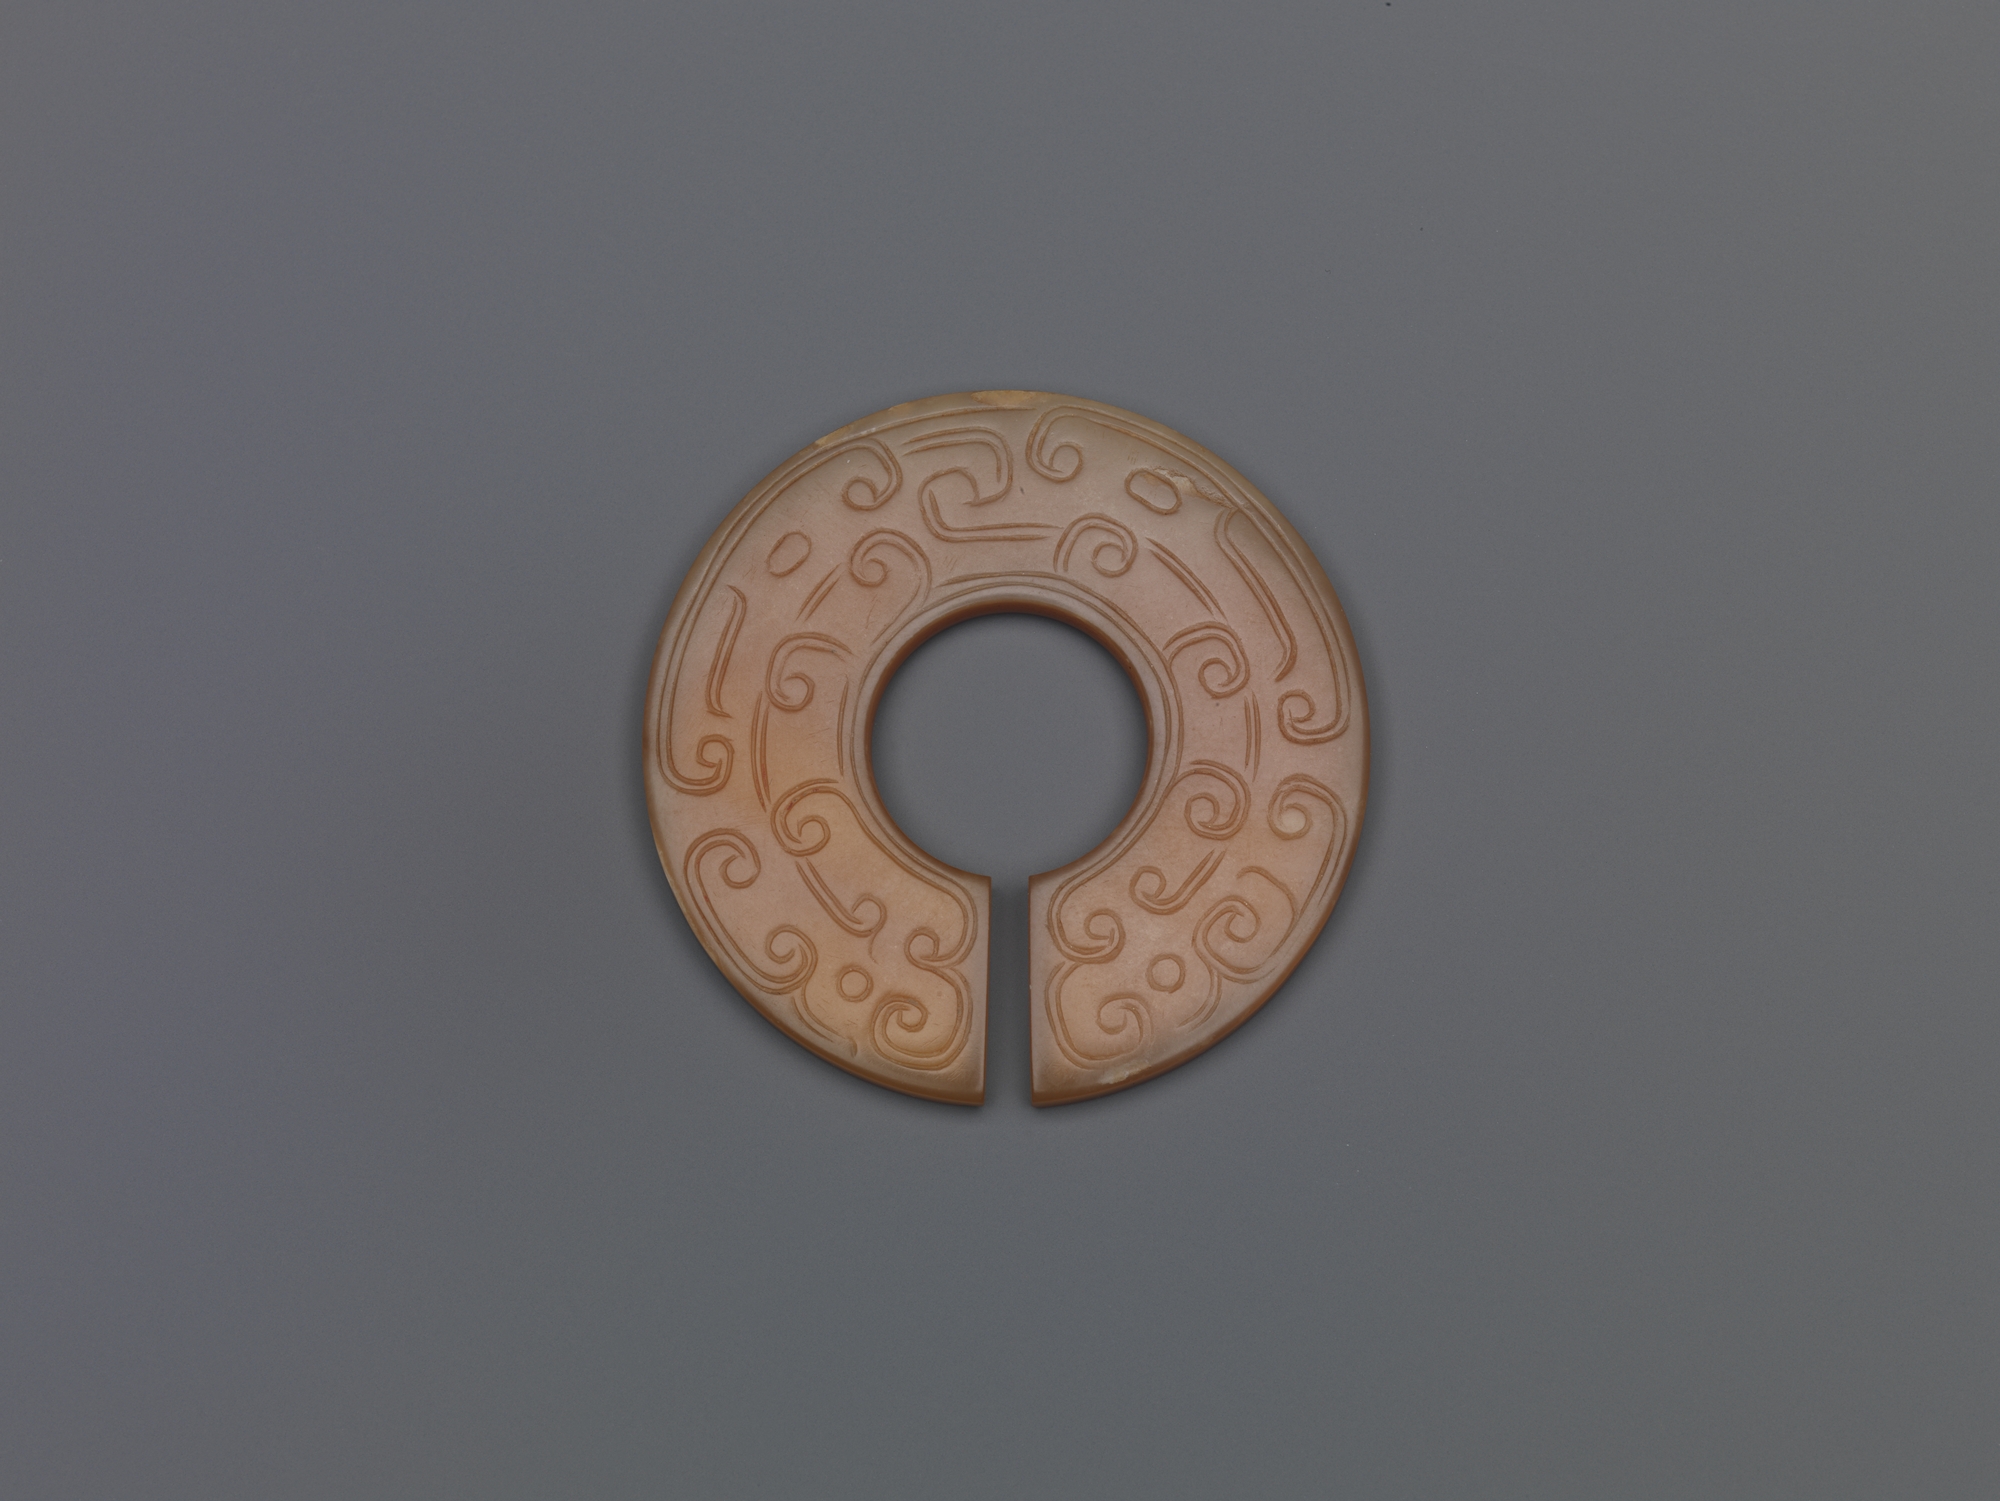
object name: ring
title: Slit Ring (Jue)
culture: chinese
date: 400-201 BCE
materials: jade